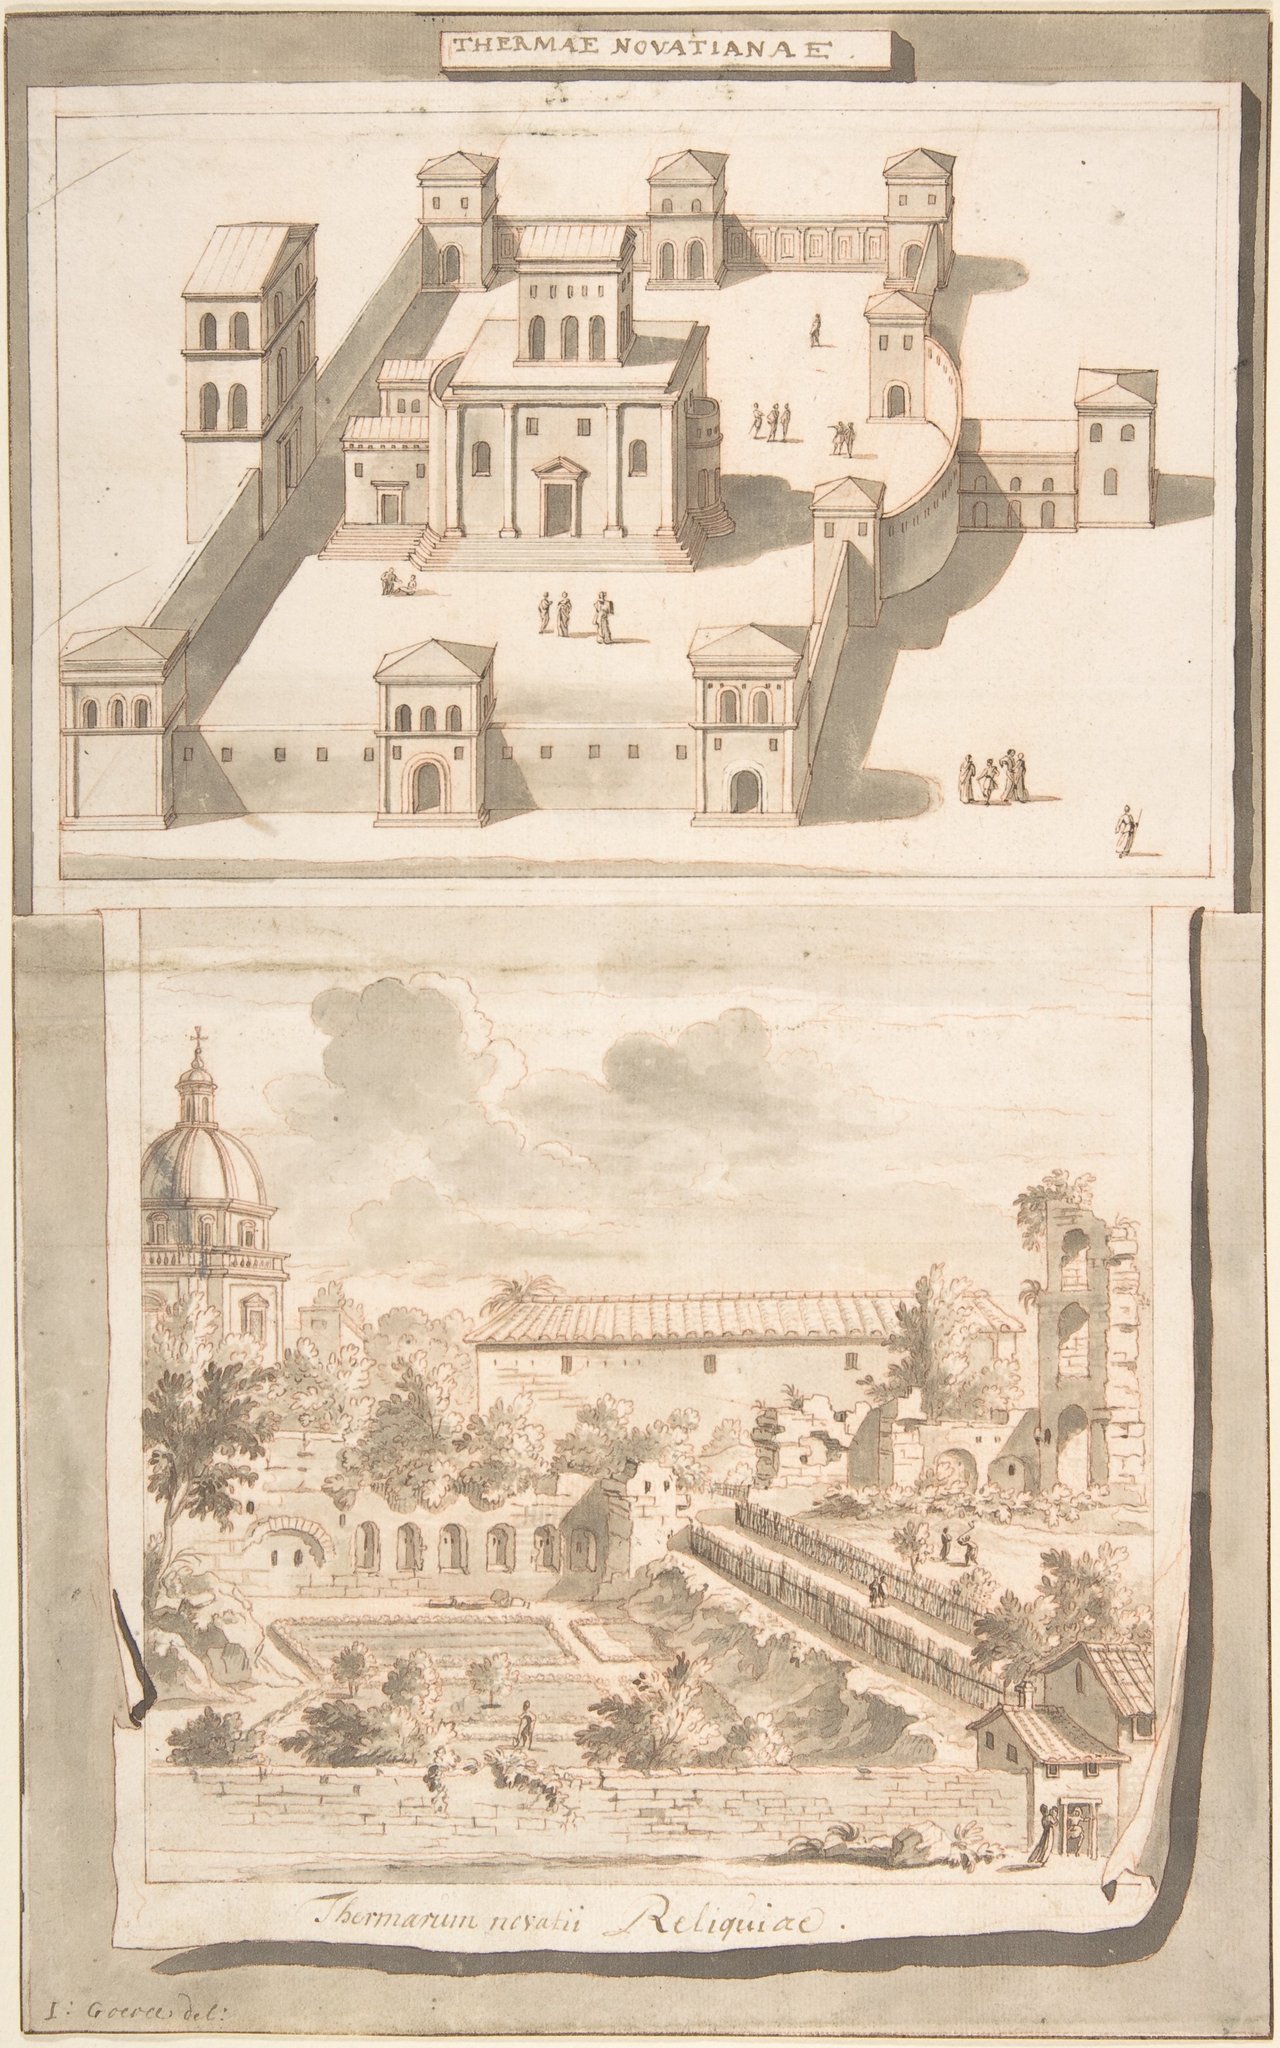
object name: drawing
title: A Reconstruction of the Thermae of Novitian (above) and a View of the Ruins (below)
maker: jan goeree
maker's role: artist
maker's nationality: dutch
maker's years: 1670-1731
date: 1704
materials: chalk, ink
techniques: brush, pen, wash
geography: italy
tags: buildings,ruins,trees